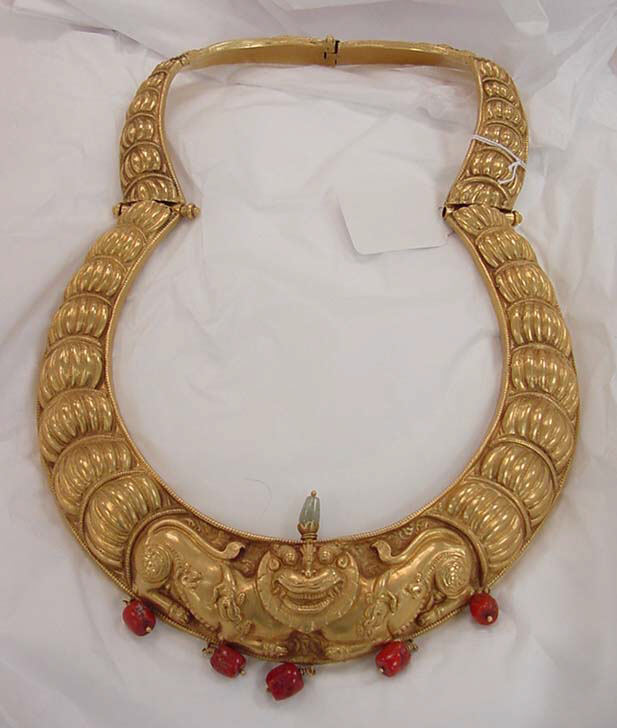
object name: necklace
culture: italian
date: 1801-1900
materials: coral, gold, jade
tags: lions